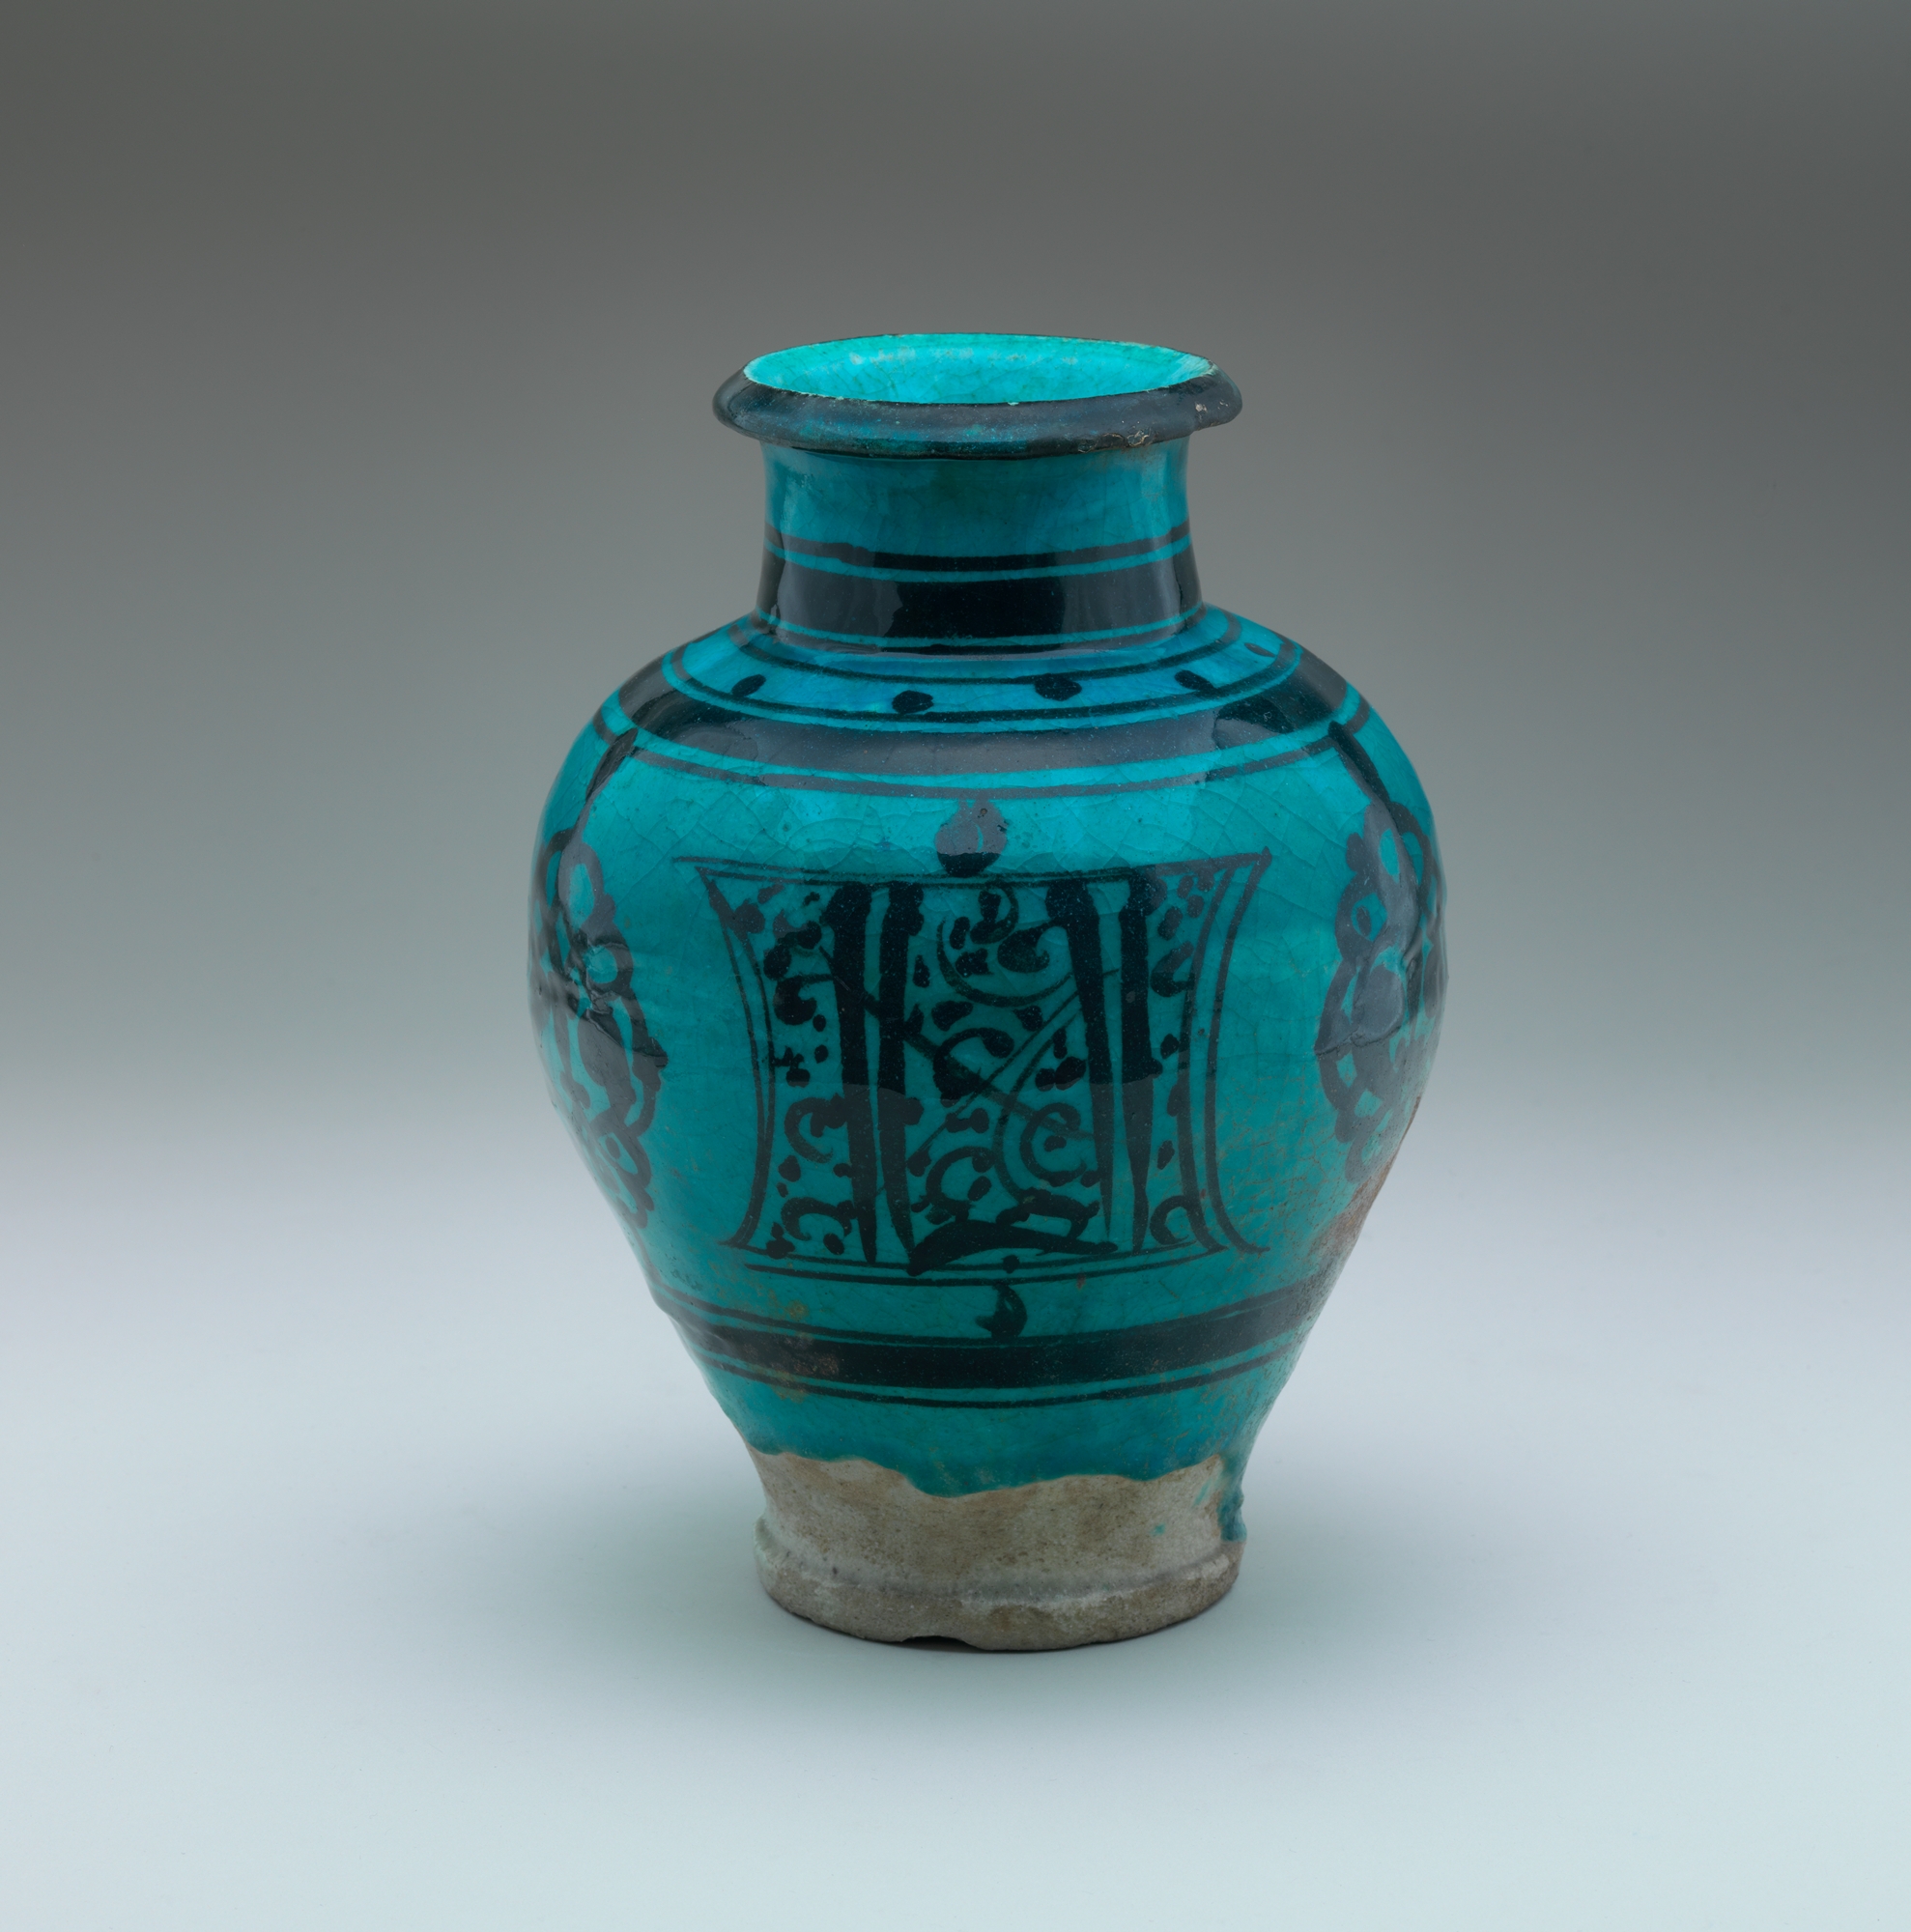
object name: jar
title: Pear-Shaped Jar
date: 1201-1250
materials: glaze, stonepaste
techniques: painting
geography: syria